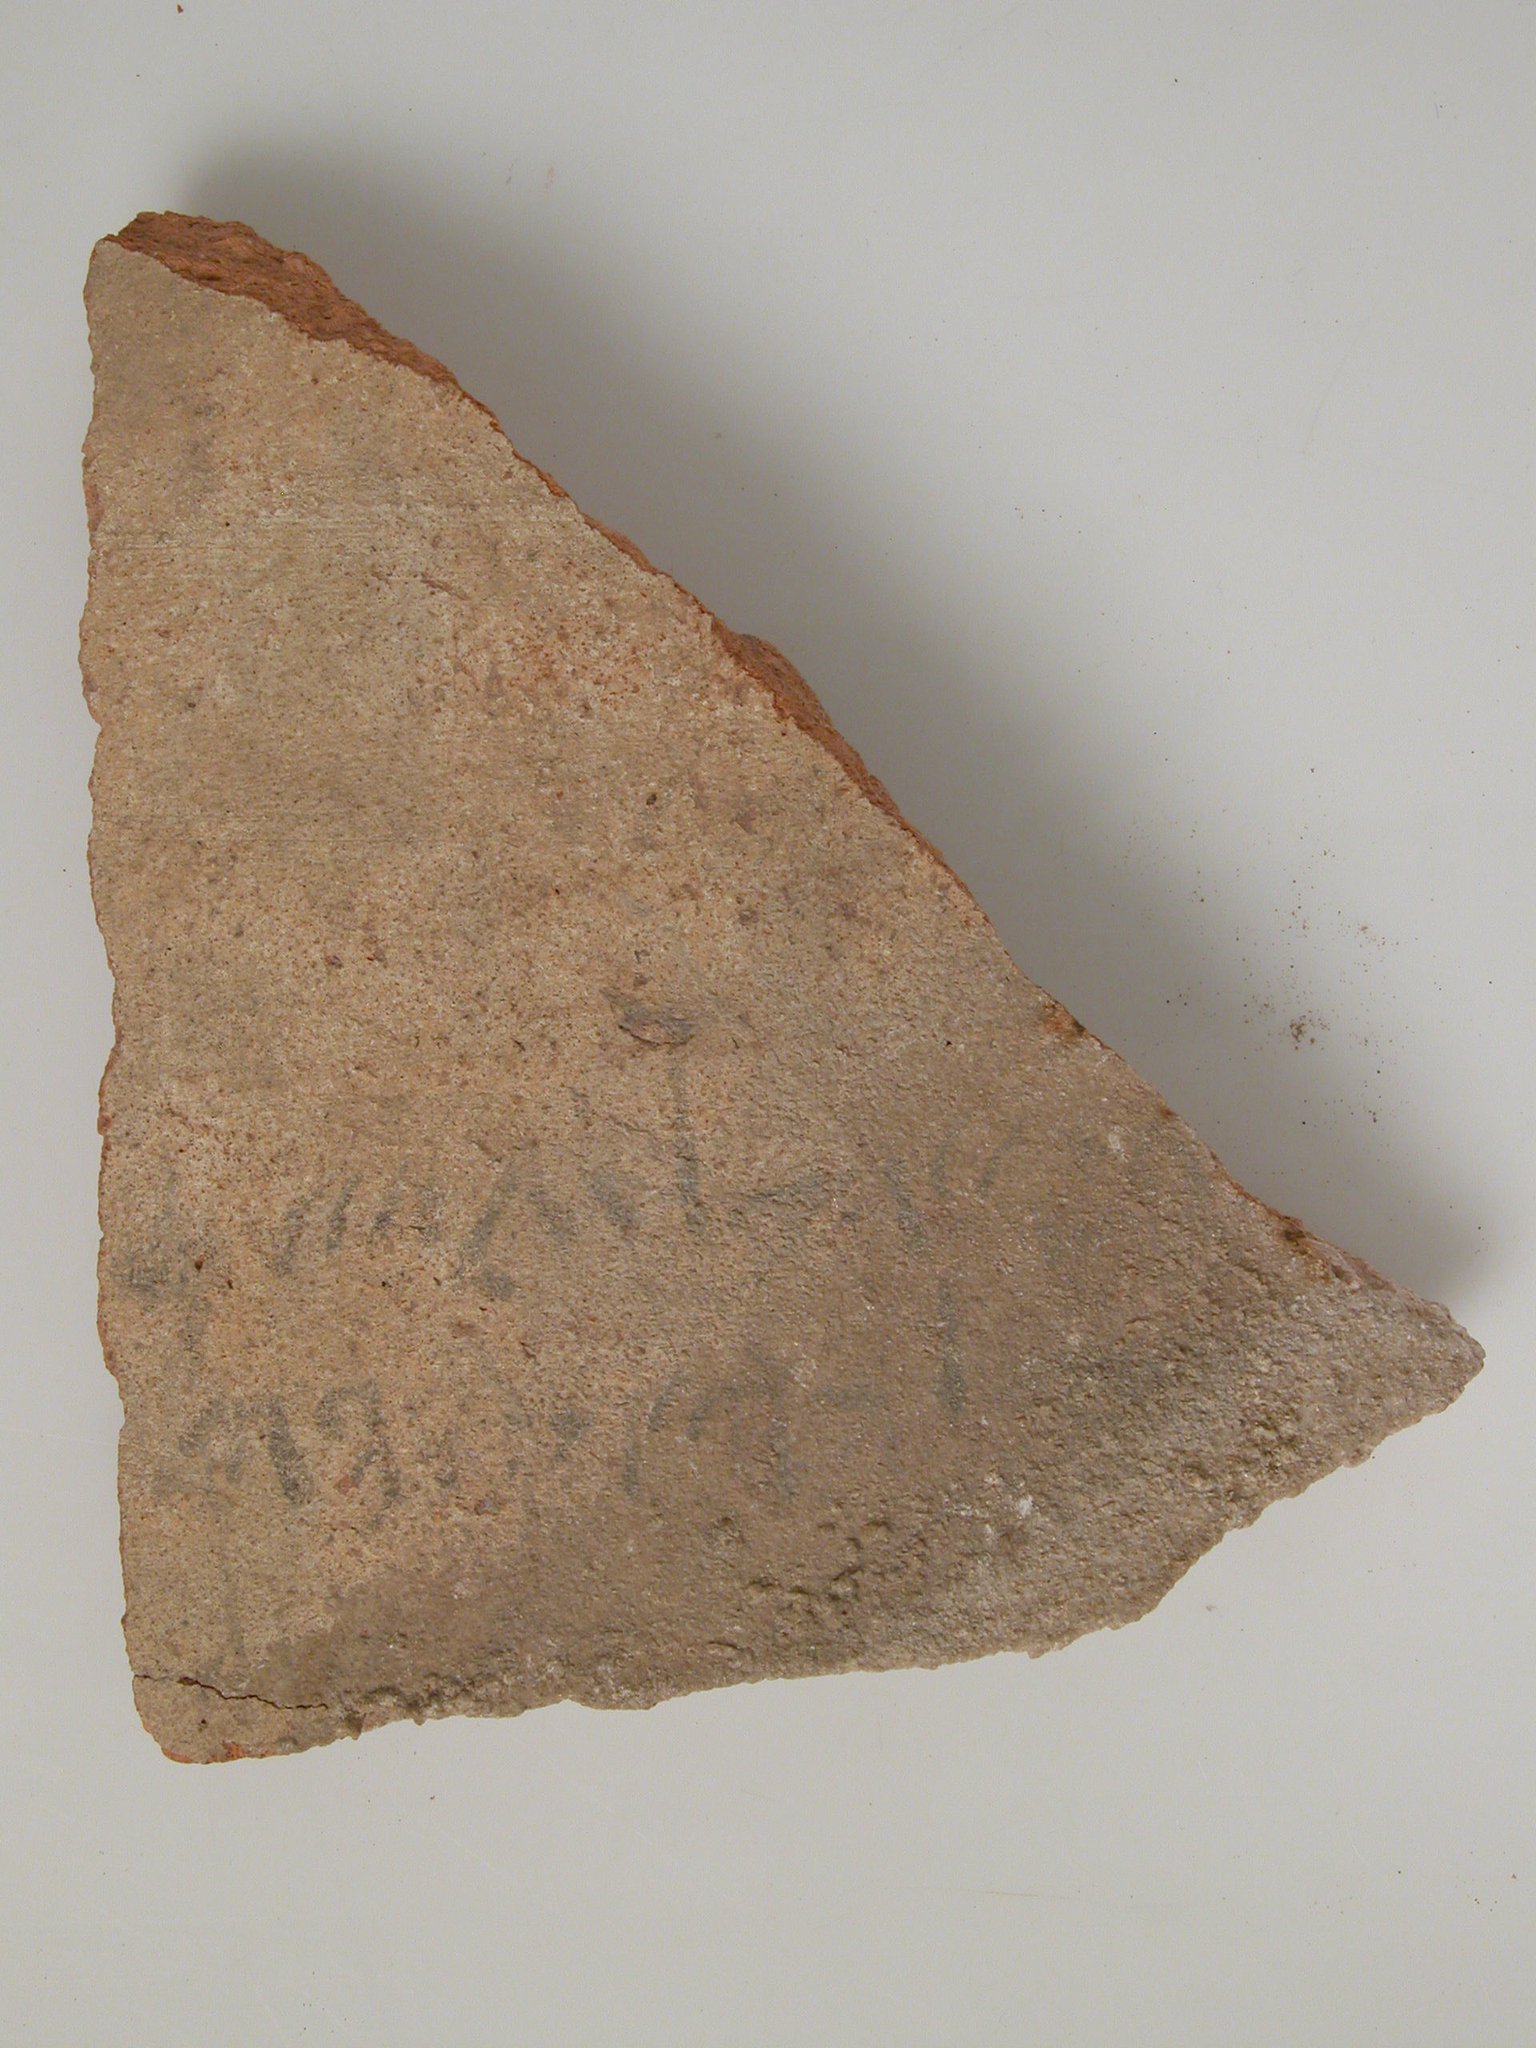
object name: ostracon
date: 400-30 BCE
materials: ink, pottery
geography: egypt